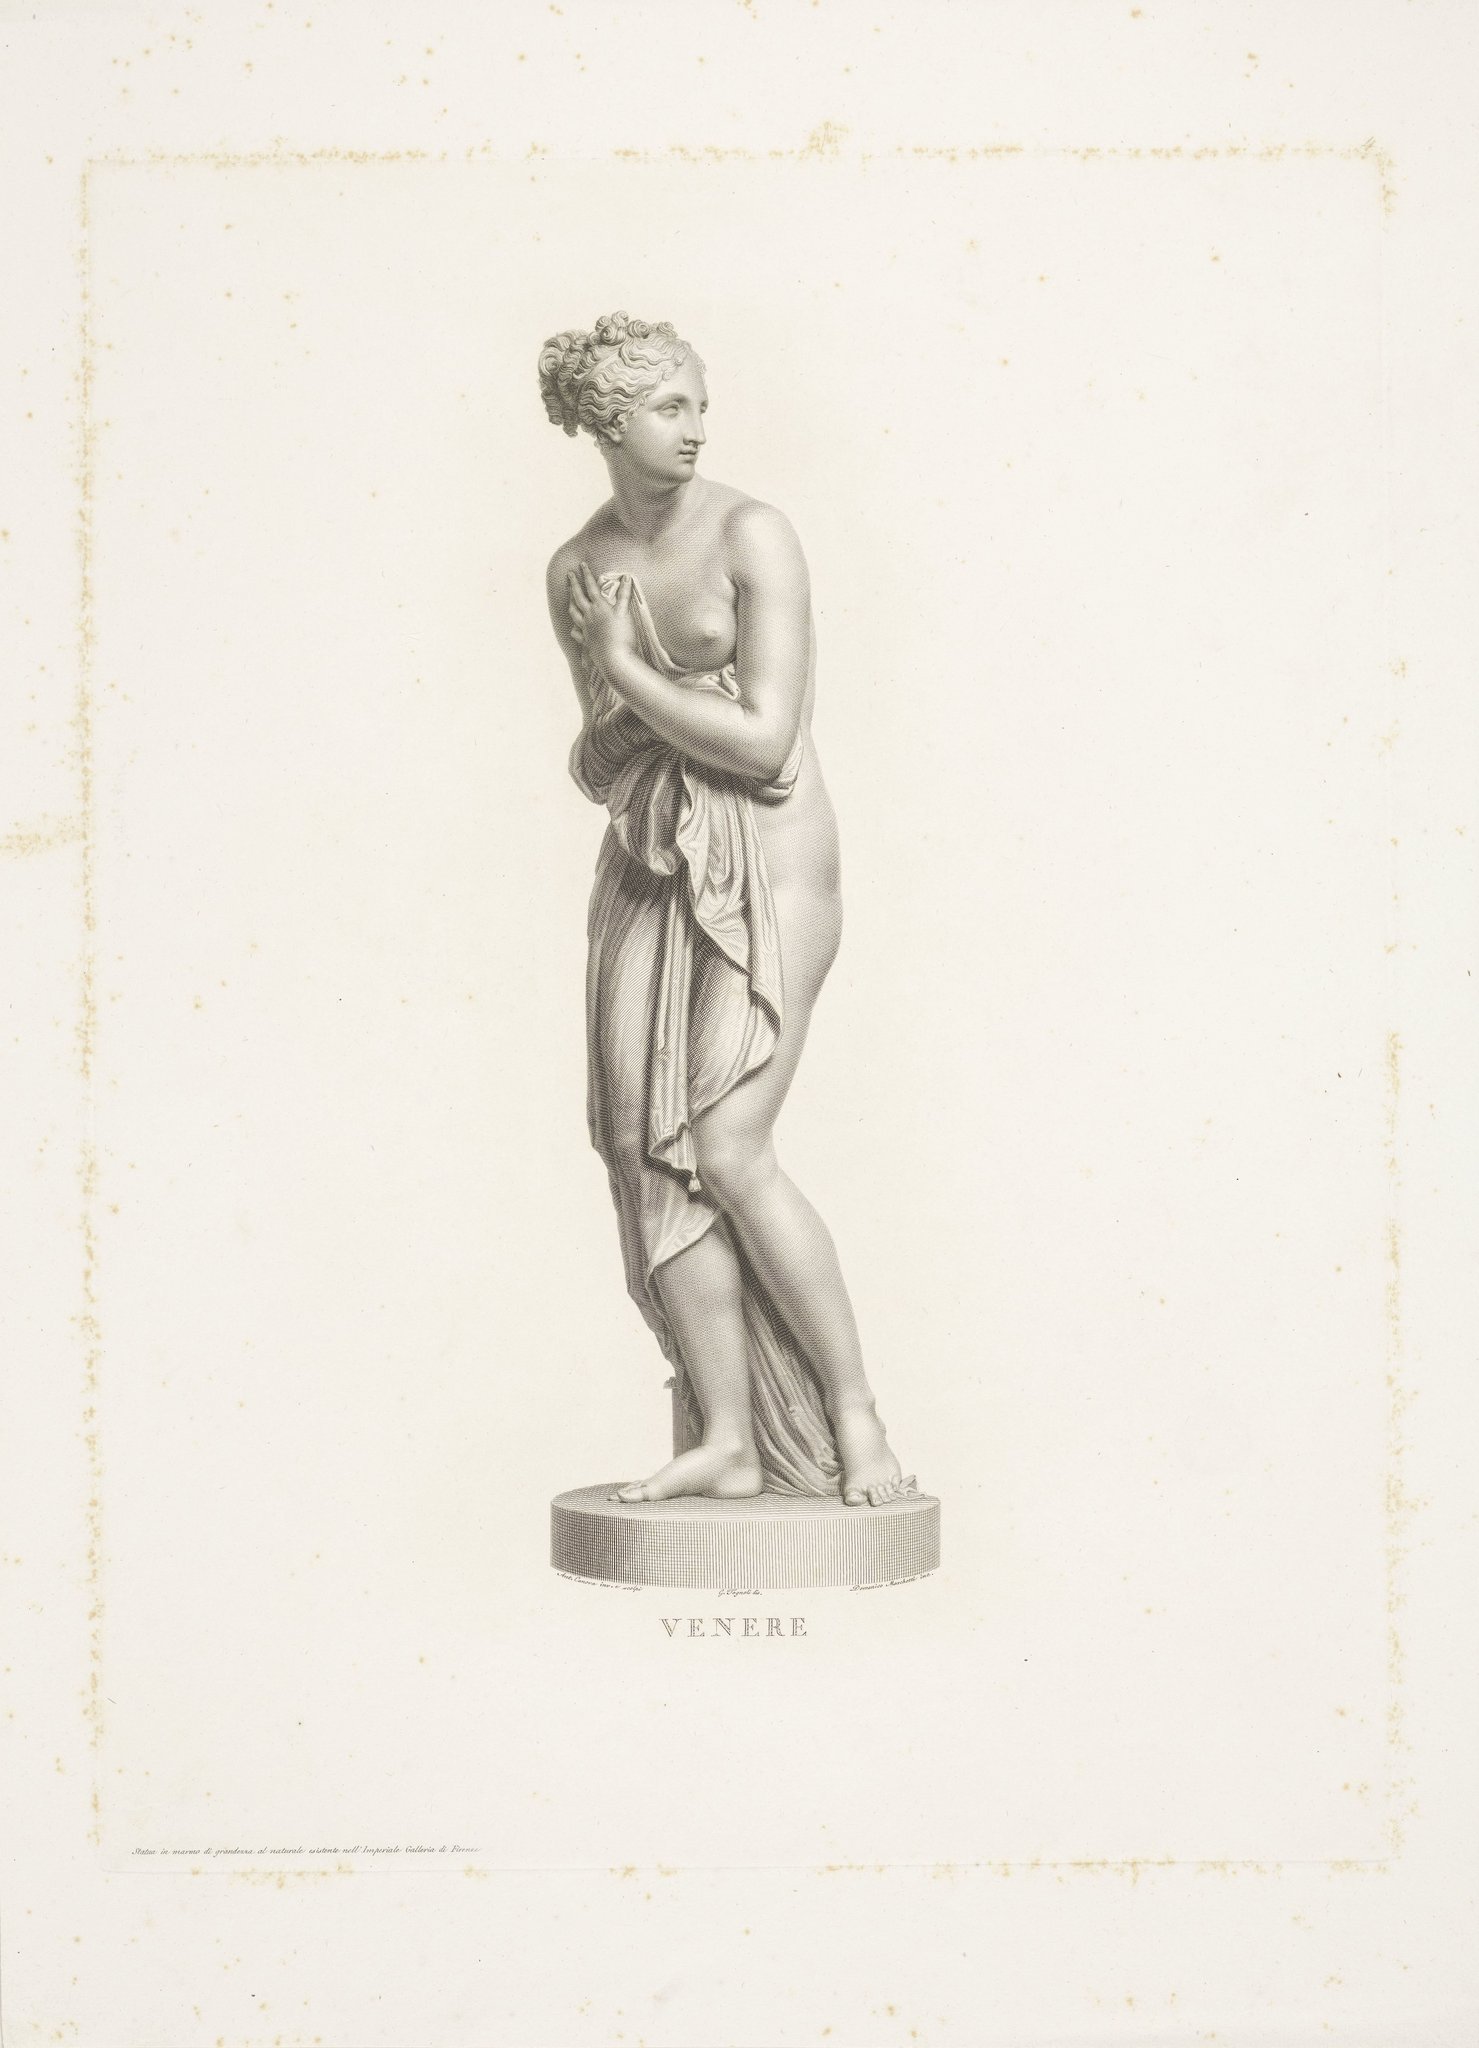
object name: print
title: Venere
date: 1790-1844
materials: paper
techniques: engraving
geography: italy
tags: piece of sculpture, reproduction of a piece of sculpture, (story of) venus (aphrodite)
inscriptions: collector's mark: Lugt 12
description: Deze prent maakt deel uit van een reeks van onbekende omvang met voorstellingen van sculpturen van Antonio Canova door verschillende prentmakers naar tekeningen van Giovanni Tognolli. Het beeld van Canova bevindt zich in de Galleria Palatina in het Palazzo Pitti te Florence.